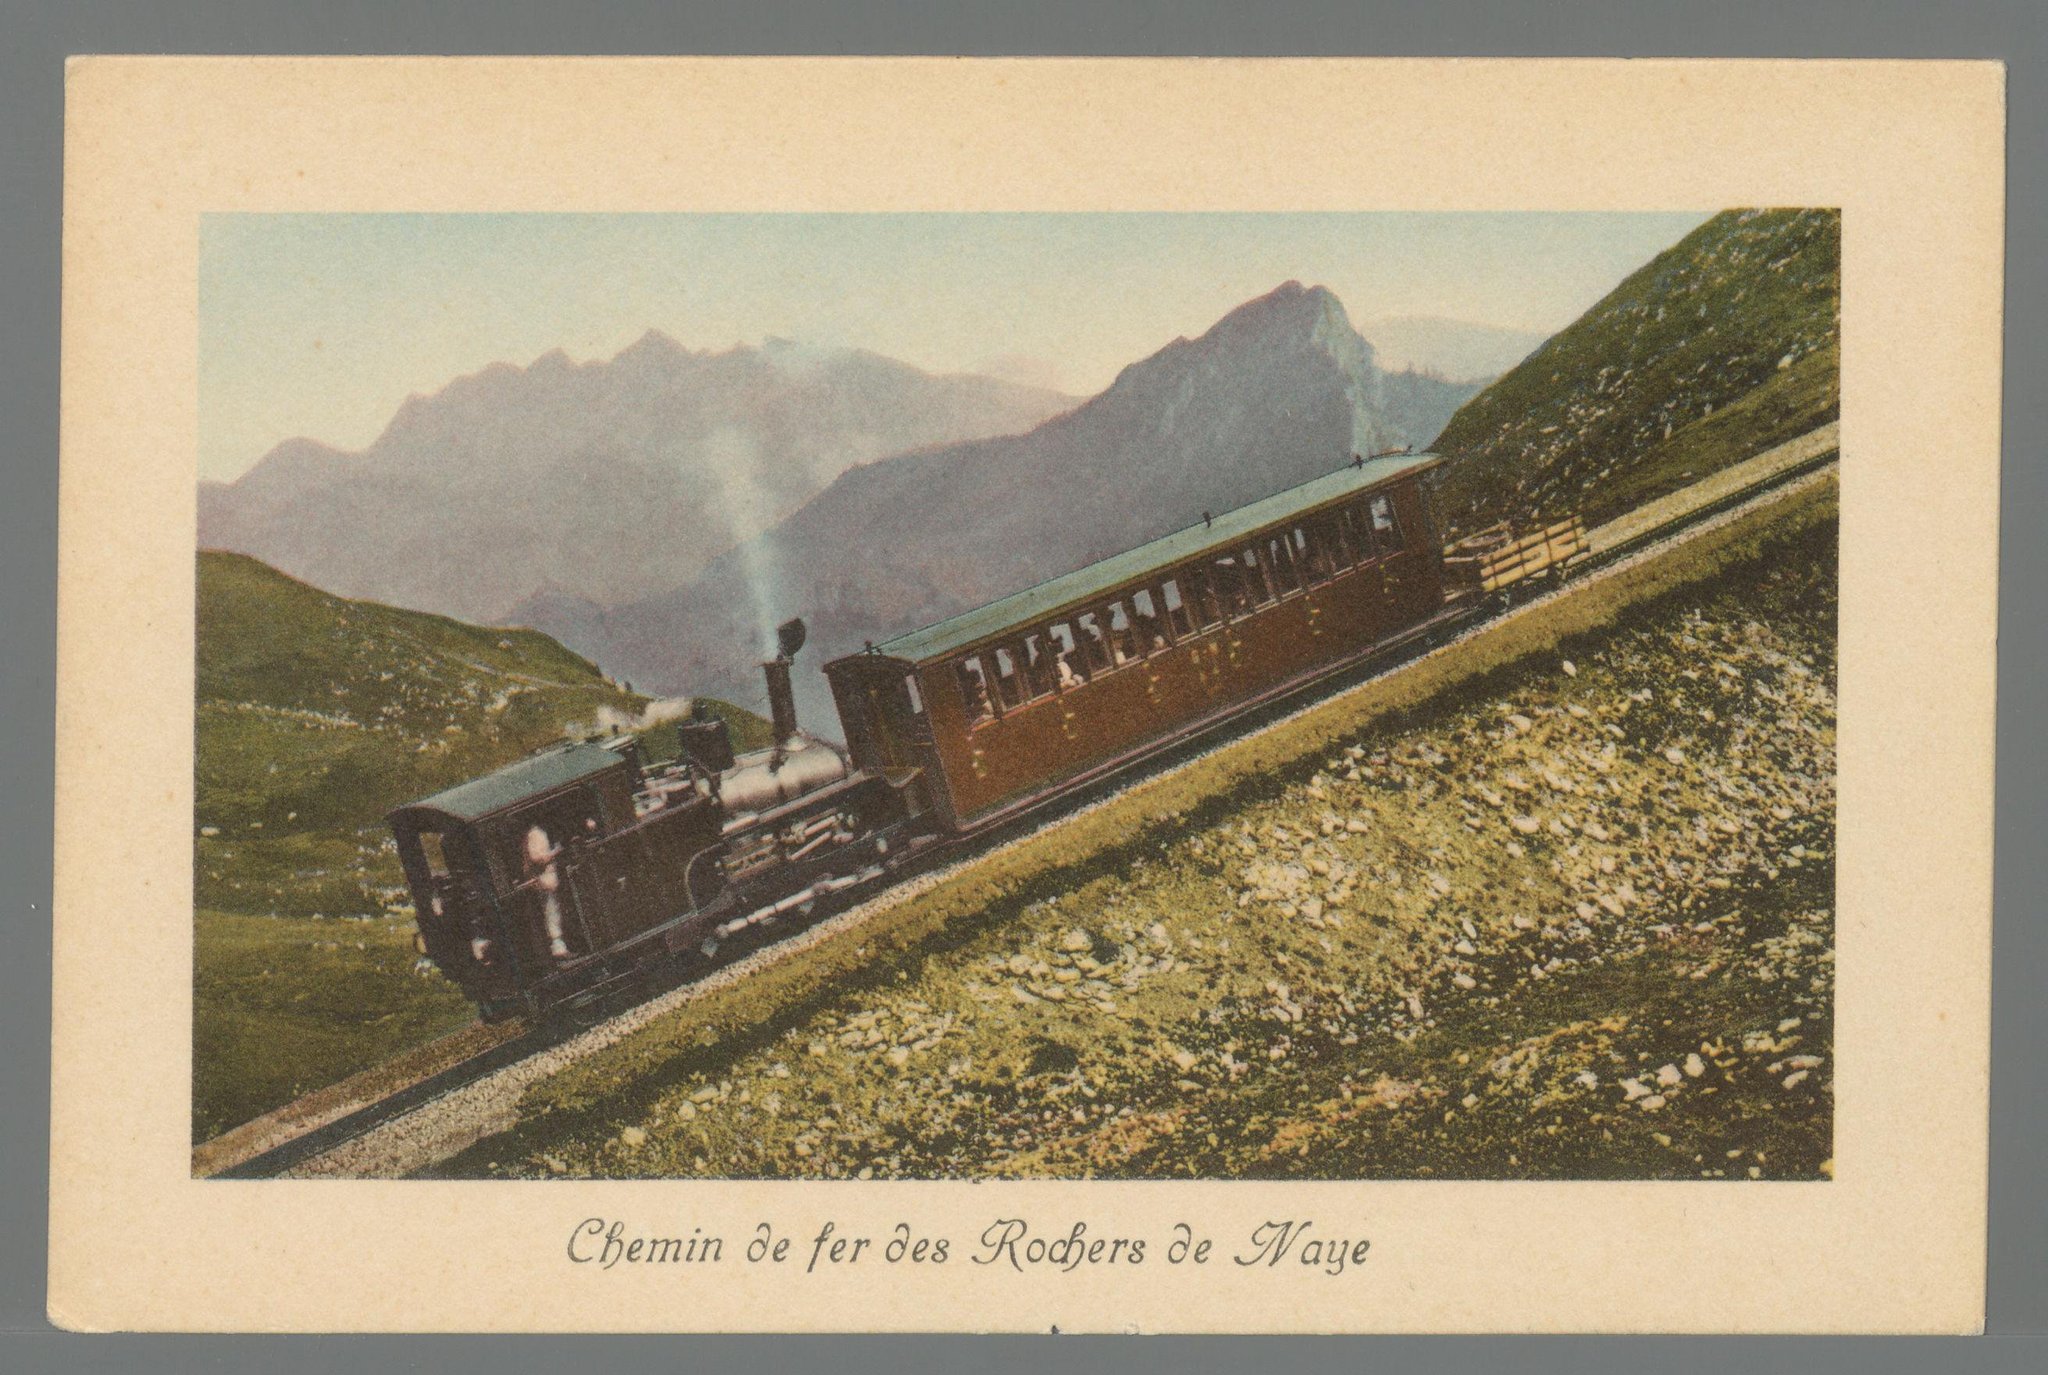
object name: photomechanical print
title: Chemin de fer des Rochers de Naye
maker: Anonymous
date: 1905-1920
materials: cardboard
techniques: photograph, lithograph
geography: geneva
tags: passenger train, mountain-range, snow peaks (+ landscape with figures, staffage)